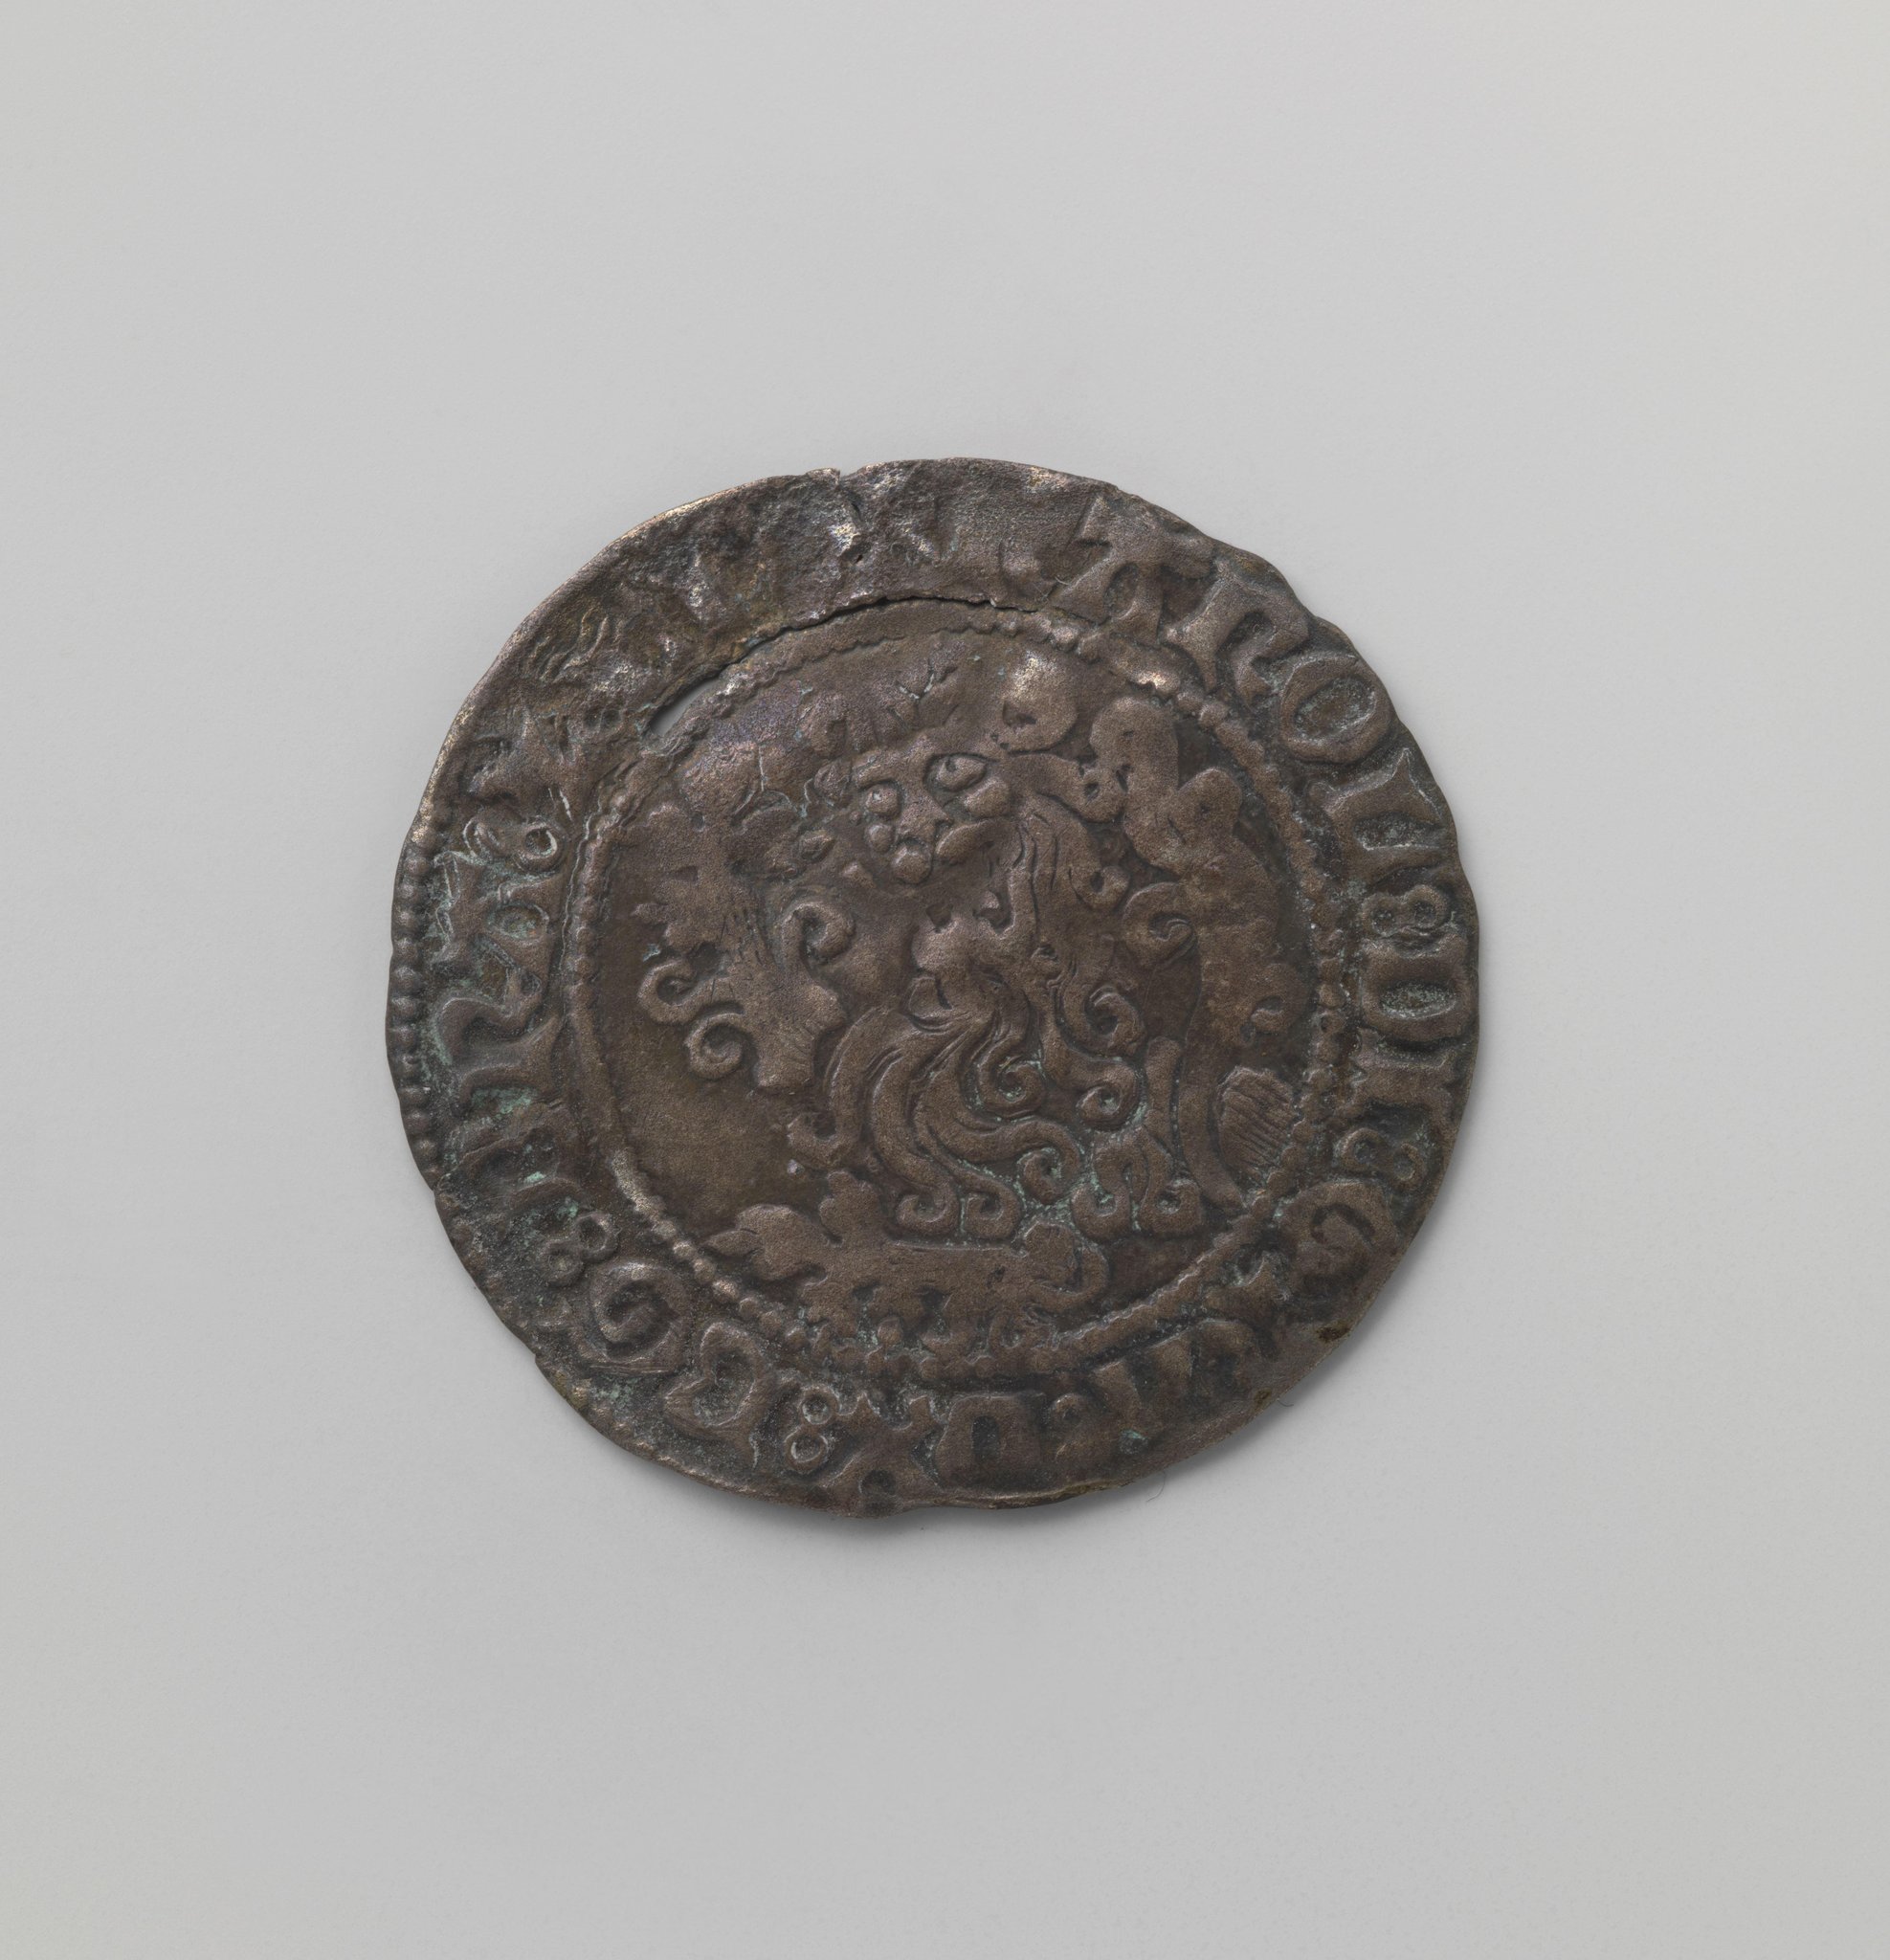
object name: coin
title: Brabant, Karel de Stoute, half vuurijzer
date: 1475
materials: silver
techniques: striking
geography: antwerp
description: Zilveren munt. Voorzijde: leeuwenkop naar links. Keerzijde: kort gebloemd kruis. Jaartal in omschrift.